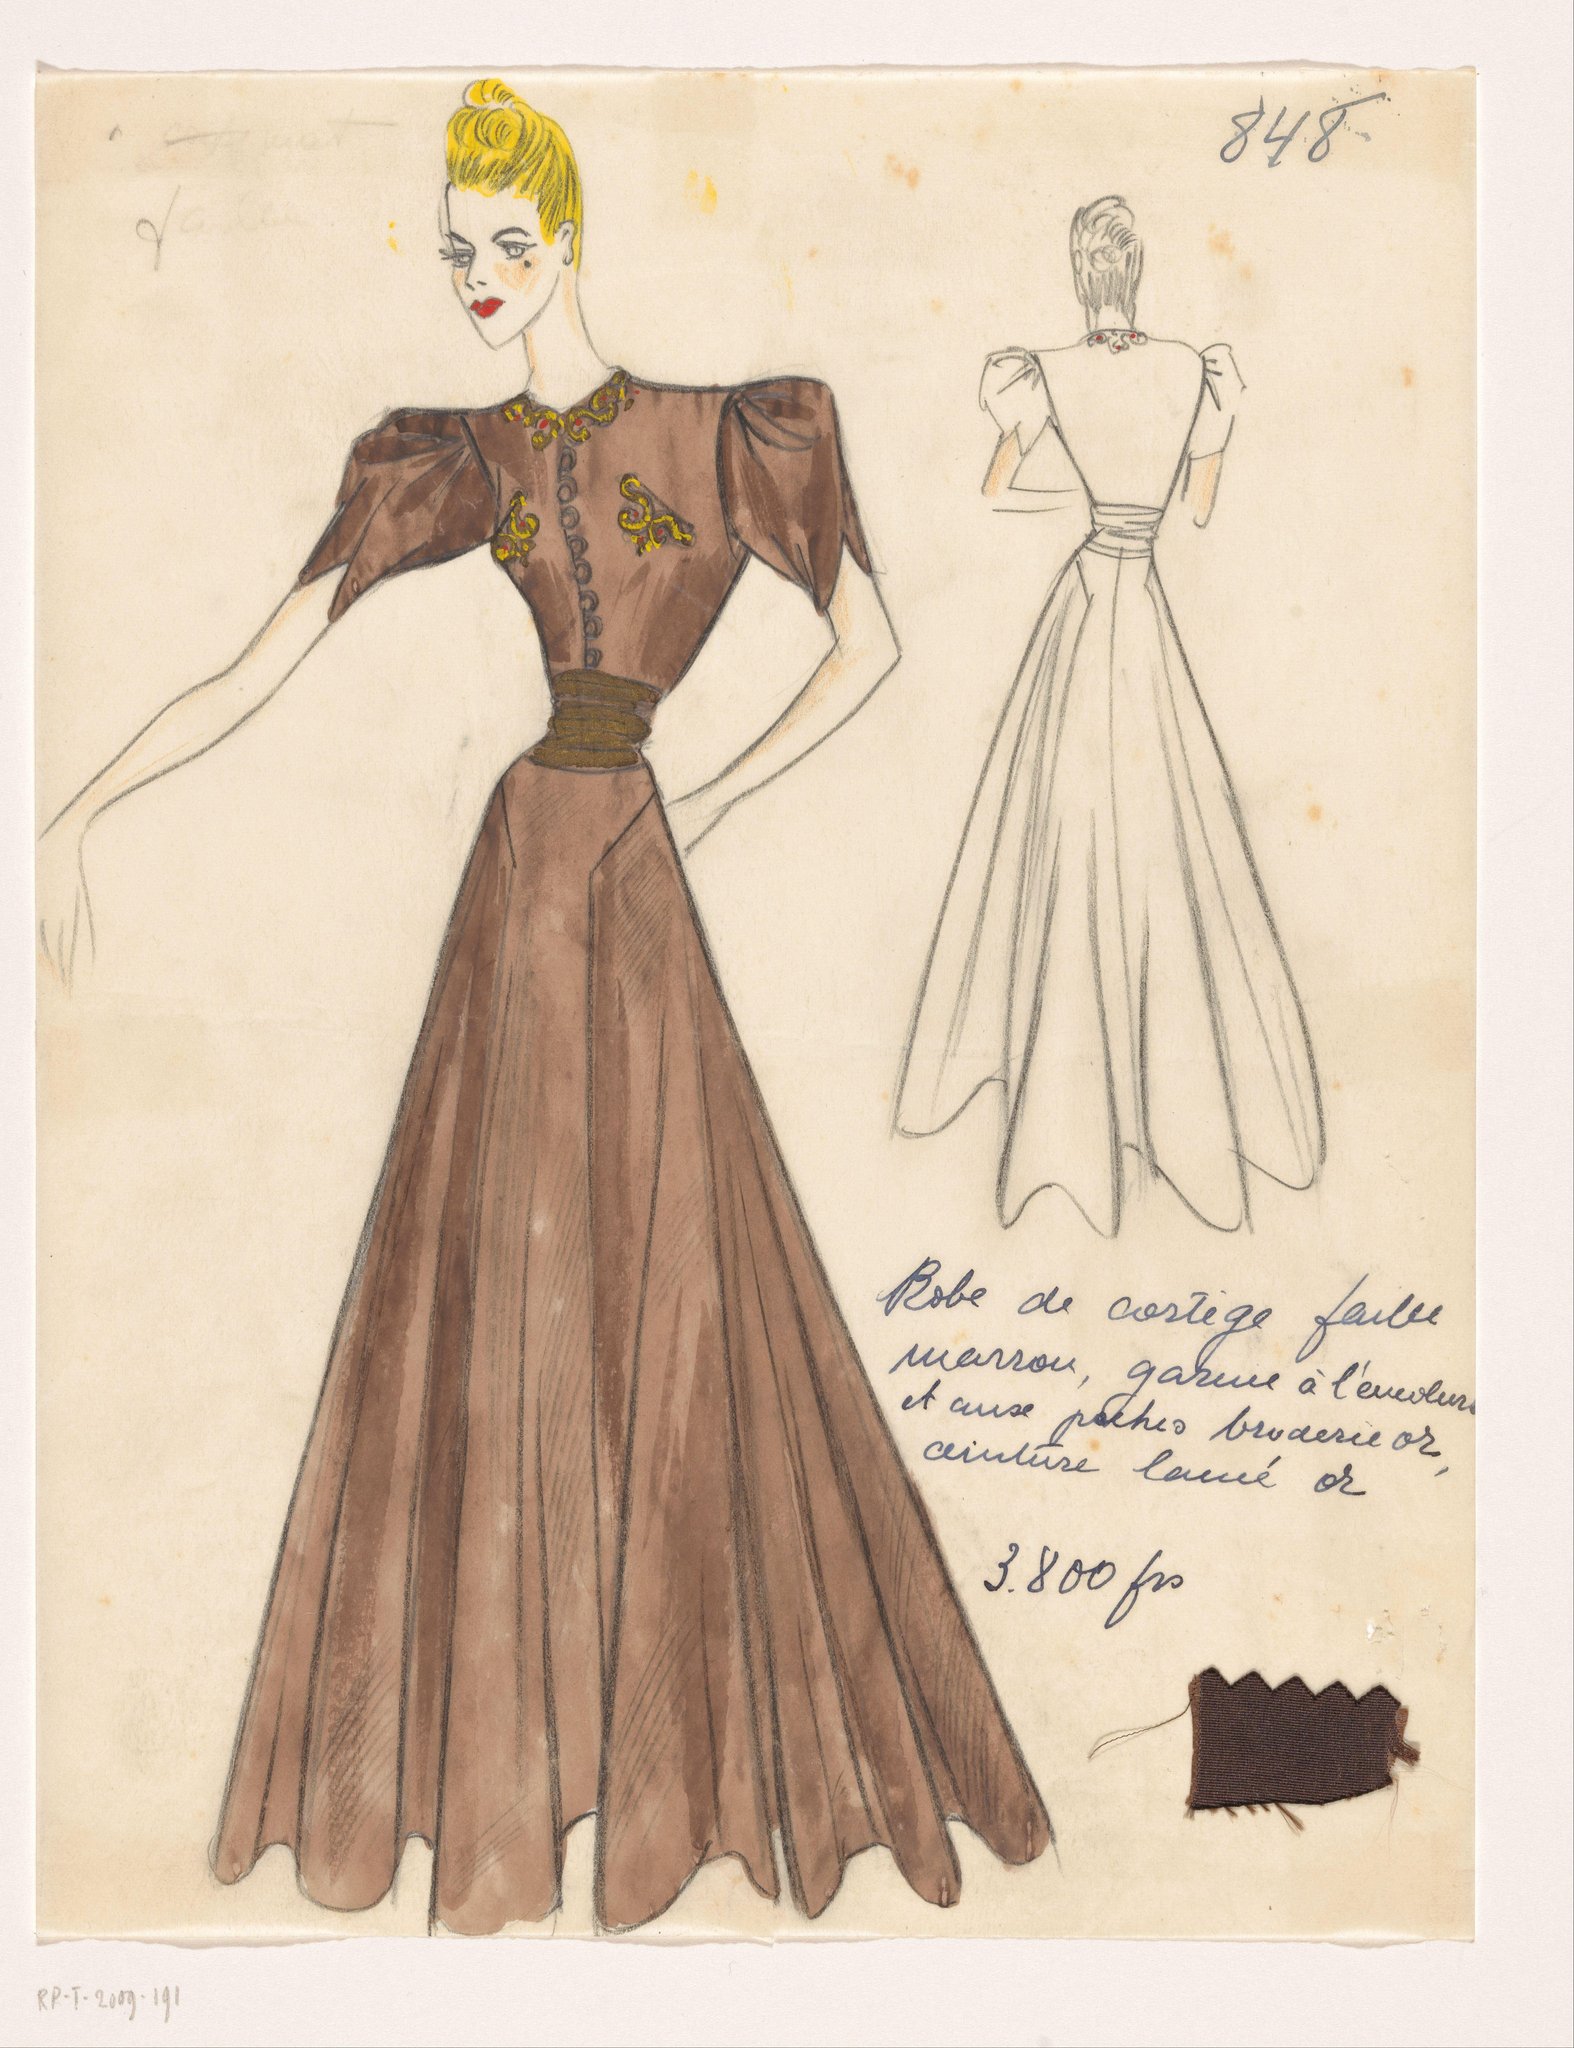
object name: fashion plate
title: Robe de cortège faille marron, garni à l'envelure et aux poches broderie or, ceinture lamé or.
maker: jean dessès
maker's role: modeontwerper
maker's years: 1904-1970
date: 1938-1939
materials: paper, pencil, watercolor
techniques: brush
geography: paris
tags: dress, gown (afternoon dress) (+ women's clothes), fashion plates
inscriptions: title: ‘Robe de cortège faille marron, garni à l'envelure et aux poches broderie or, ceinture lamé or. 3.800 frs.’, number: ‘848’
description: Avondjapon van kastanjebruine faille. Getailleerd lijf met breed uitstaande, tulpvormige halflange mouwen en twee schuin geplaatste borstzakjes. Ronde hals en knoopsluiting middenvoor. Brede ceintuur van goud lamé. Klokkende rok met schuin ingezette zijpanden. Rond de hals en de steekzakjes goudborduursel. In de rechter benedenhoek een staaltje kastanjebruine faille. Prijs: 3.800 frs.